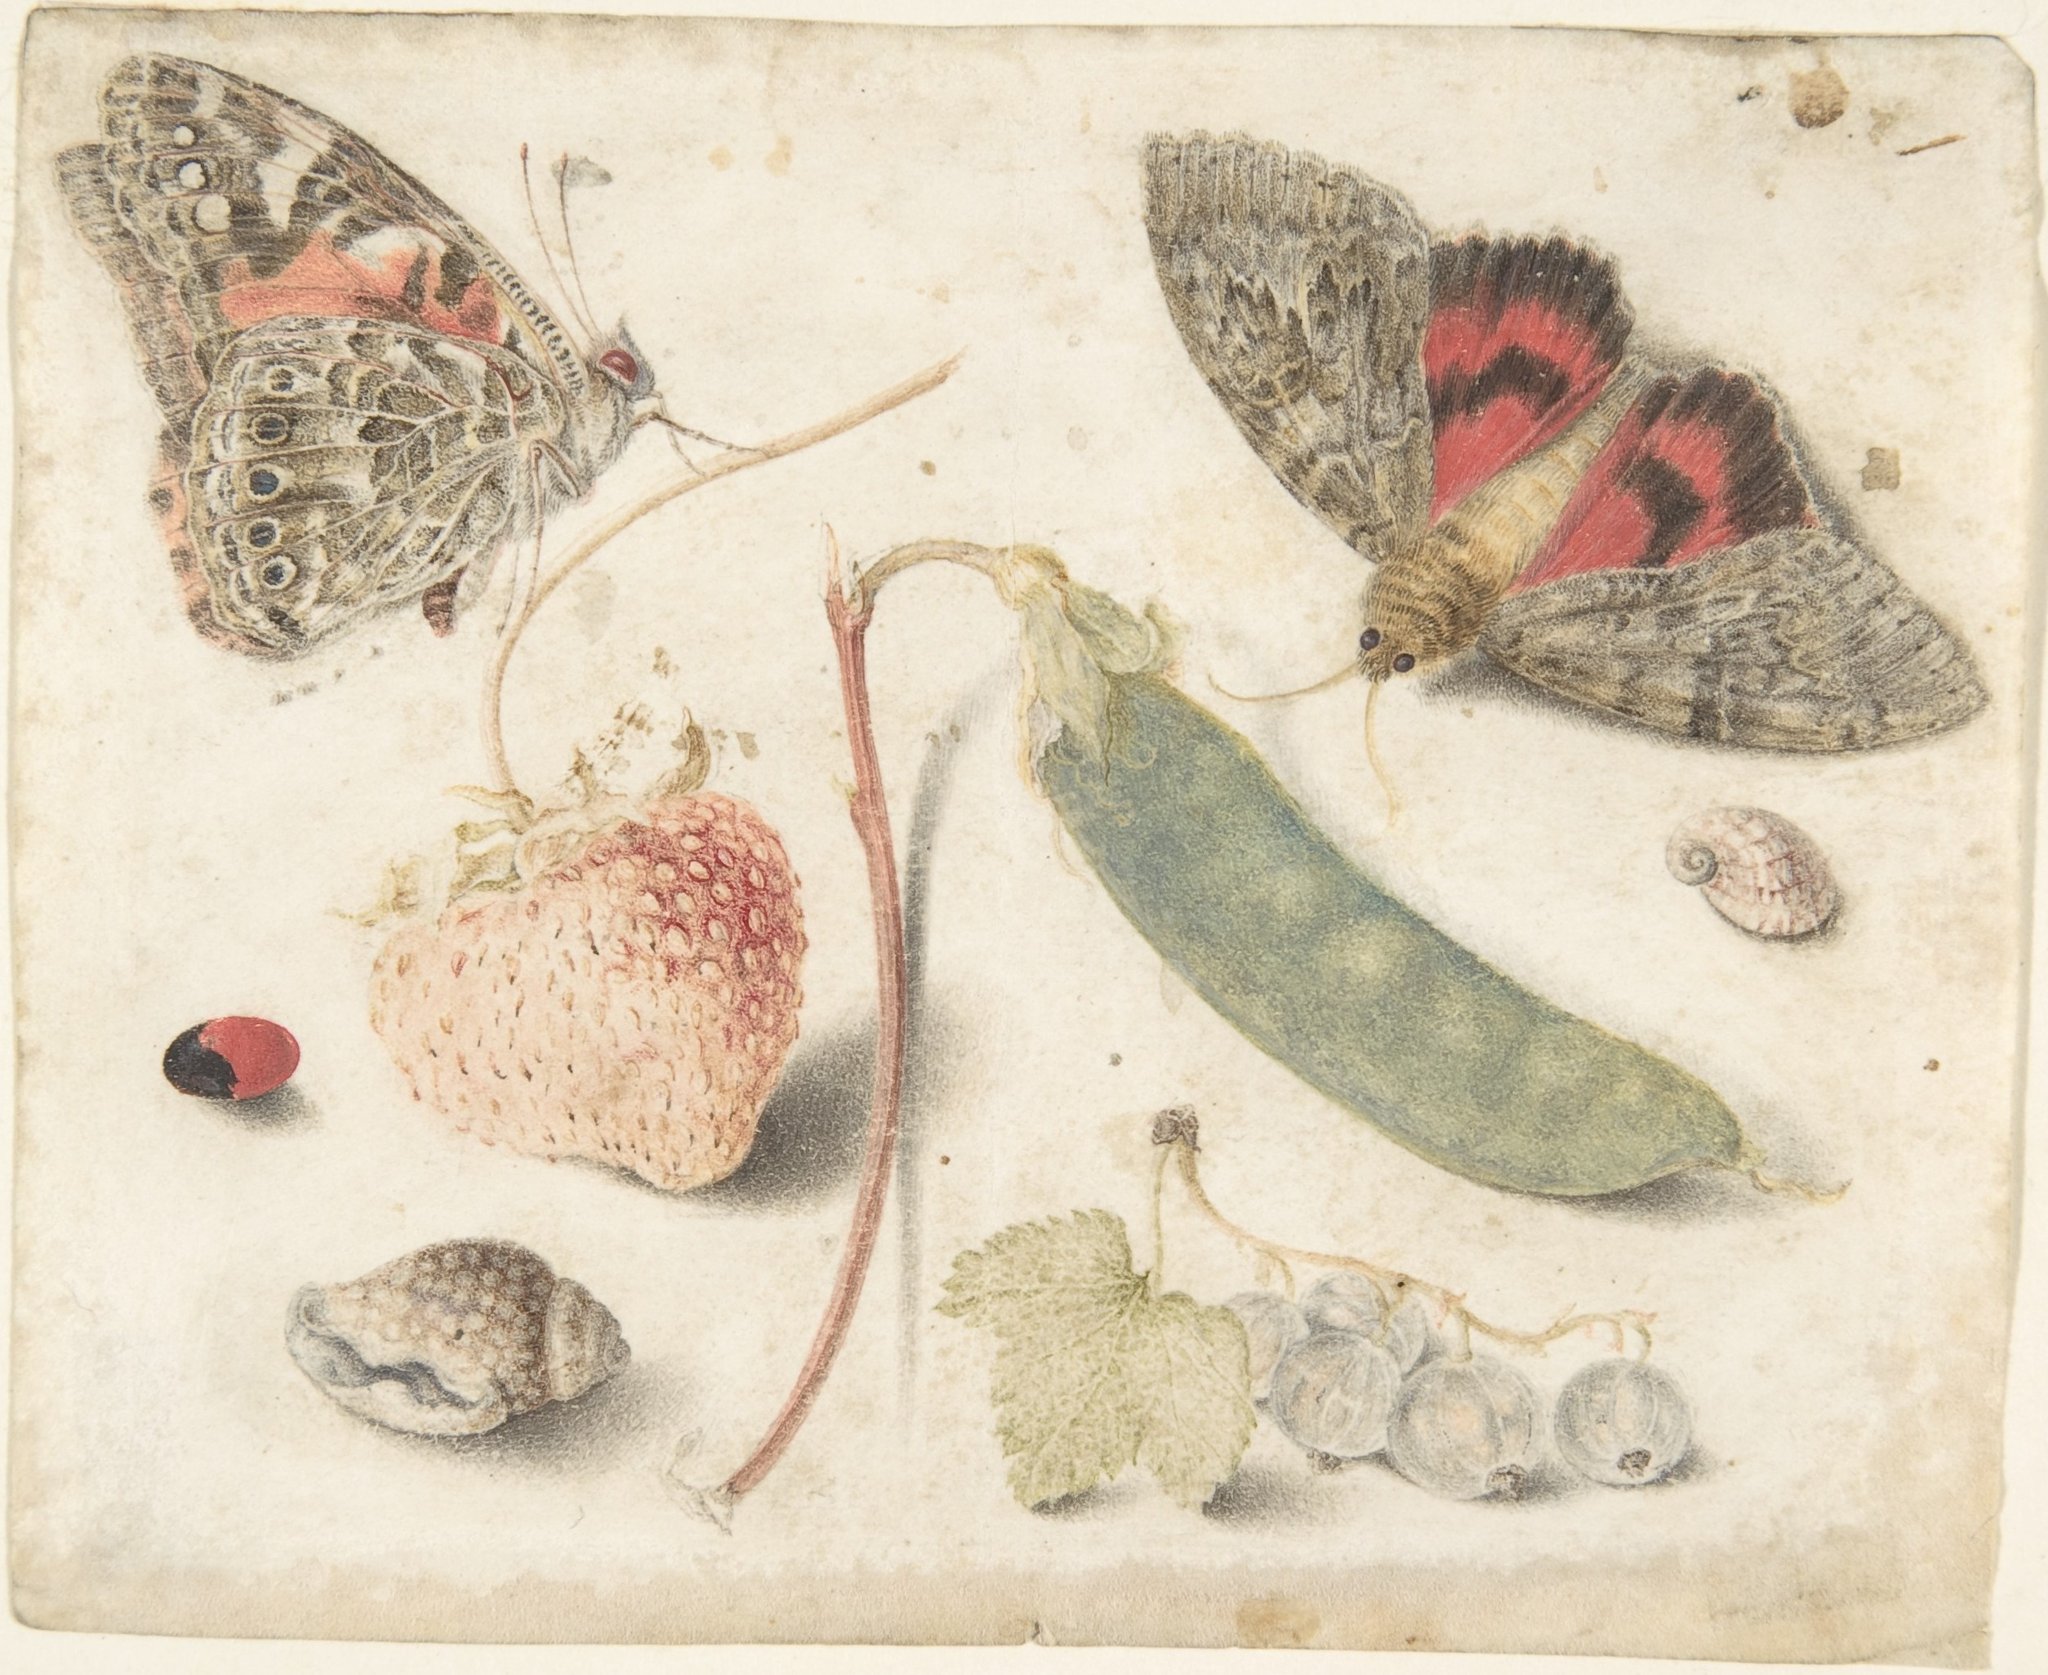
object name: drawing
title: Studies of Fruits, Insects and Shells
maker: georg flegel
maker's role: artist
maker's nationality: german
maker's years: 1566-1638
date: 1567-1666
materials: parchment, watercolor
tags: strawberries,insects,butterflies,shells